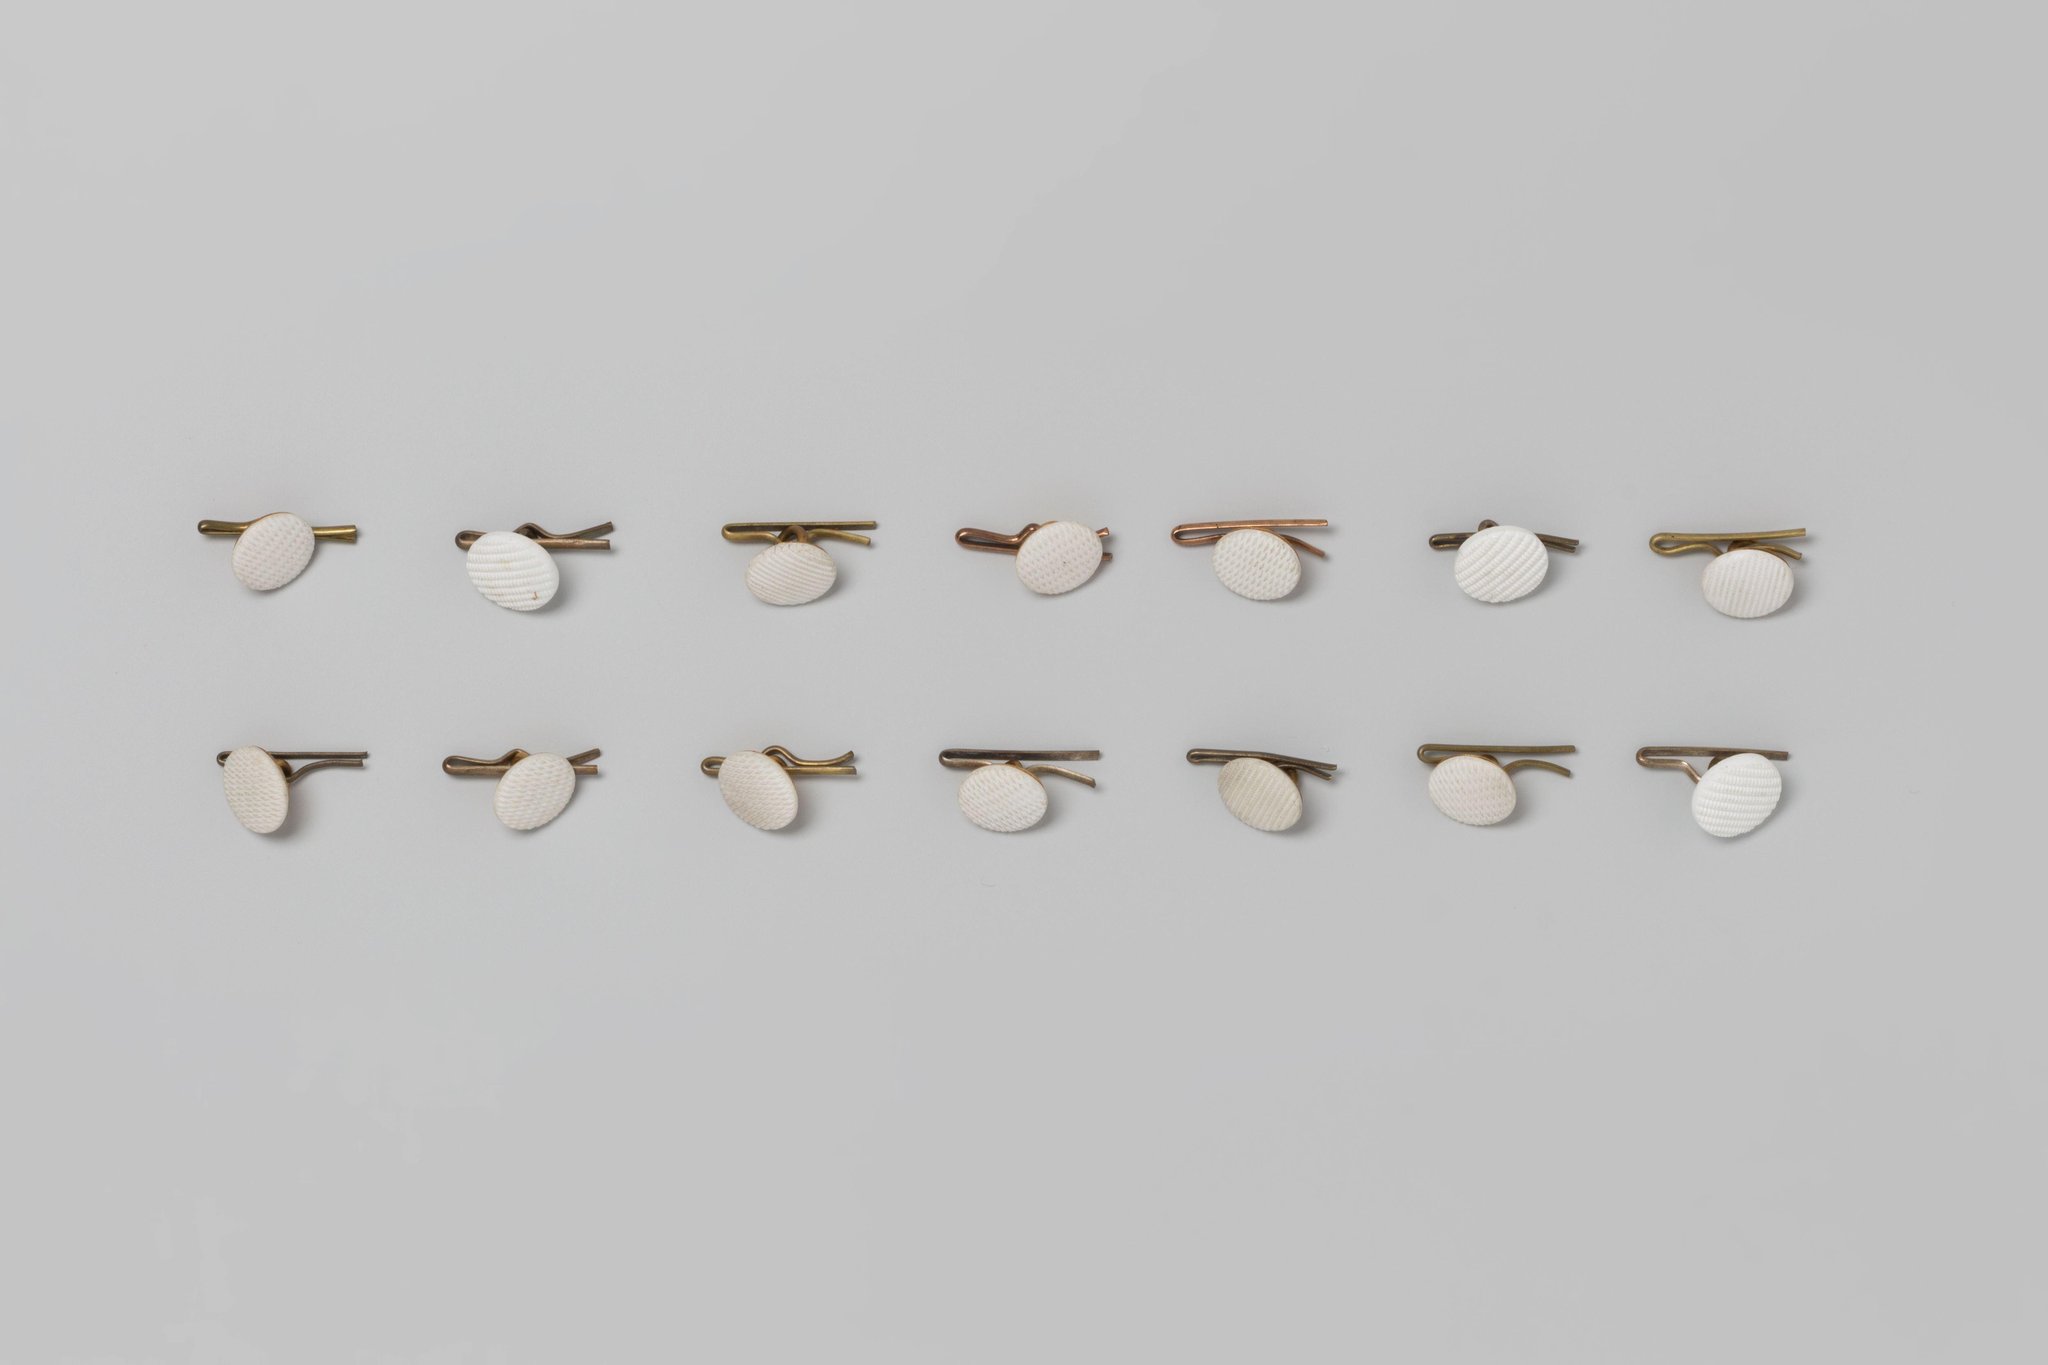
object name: menswear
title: Vestknoop van kunststof met reliëf-ribbel, vast oogje en losse tegenklem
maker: Anonymous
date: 1900-1940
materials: metal, plastic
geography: netherlands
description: Vestknoop van kunststof met reliëf-ribbel, vast oogje en losse tegenklem.